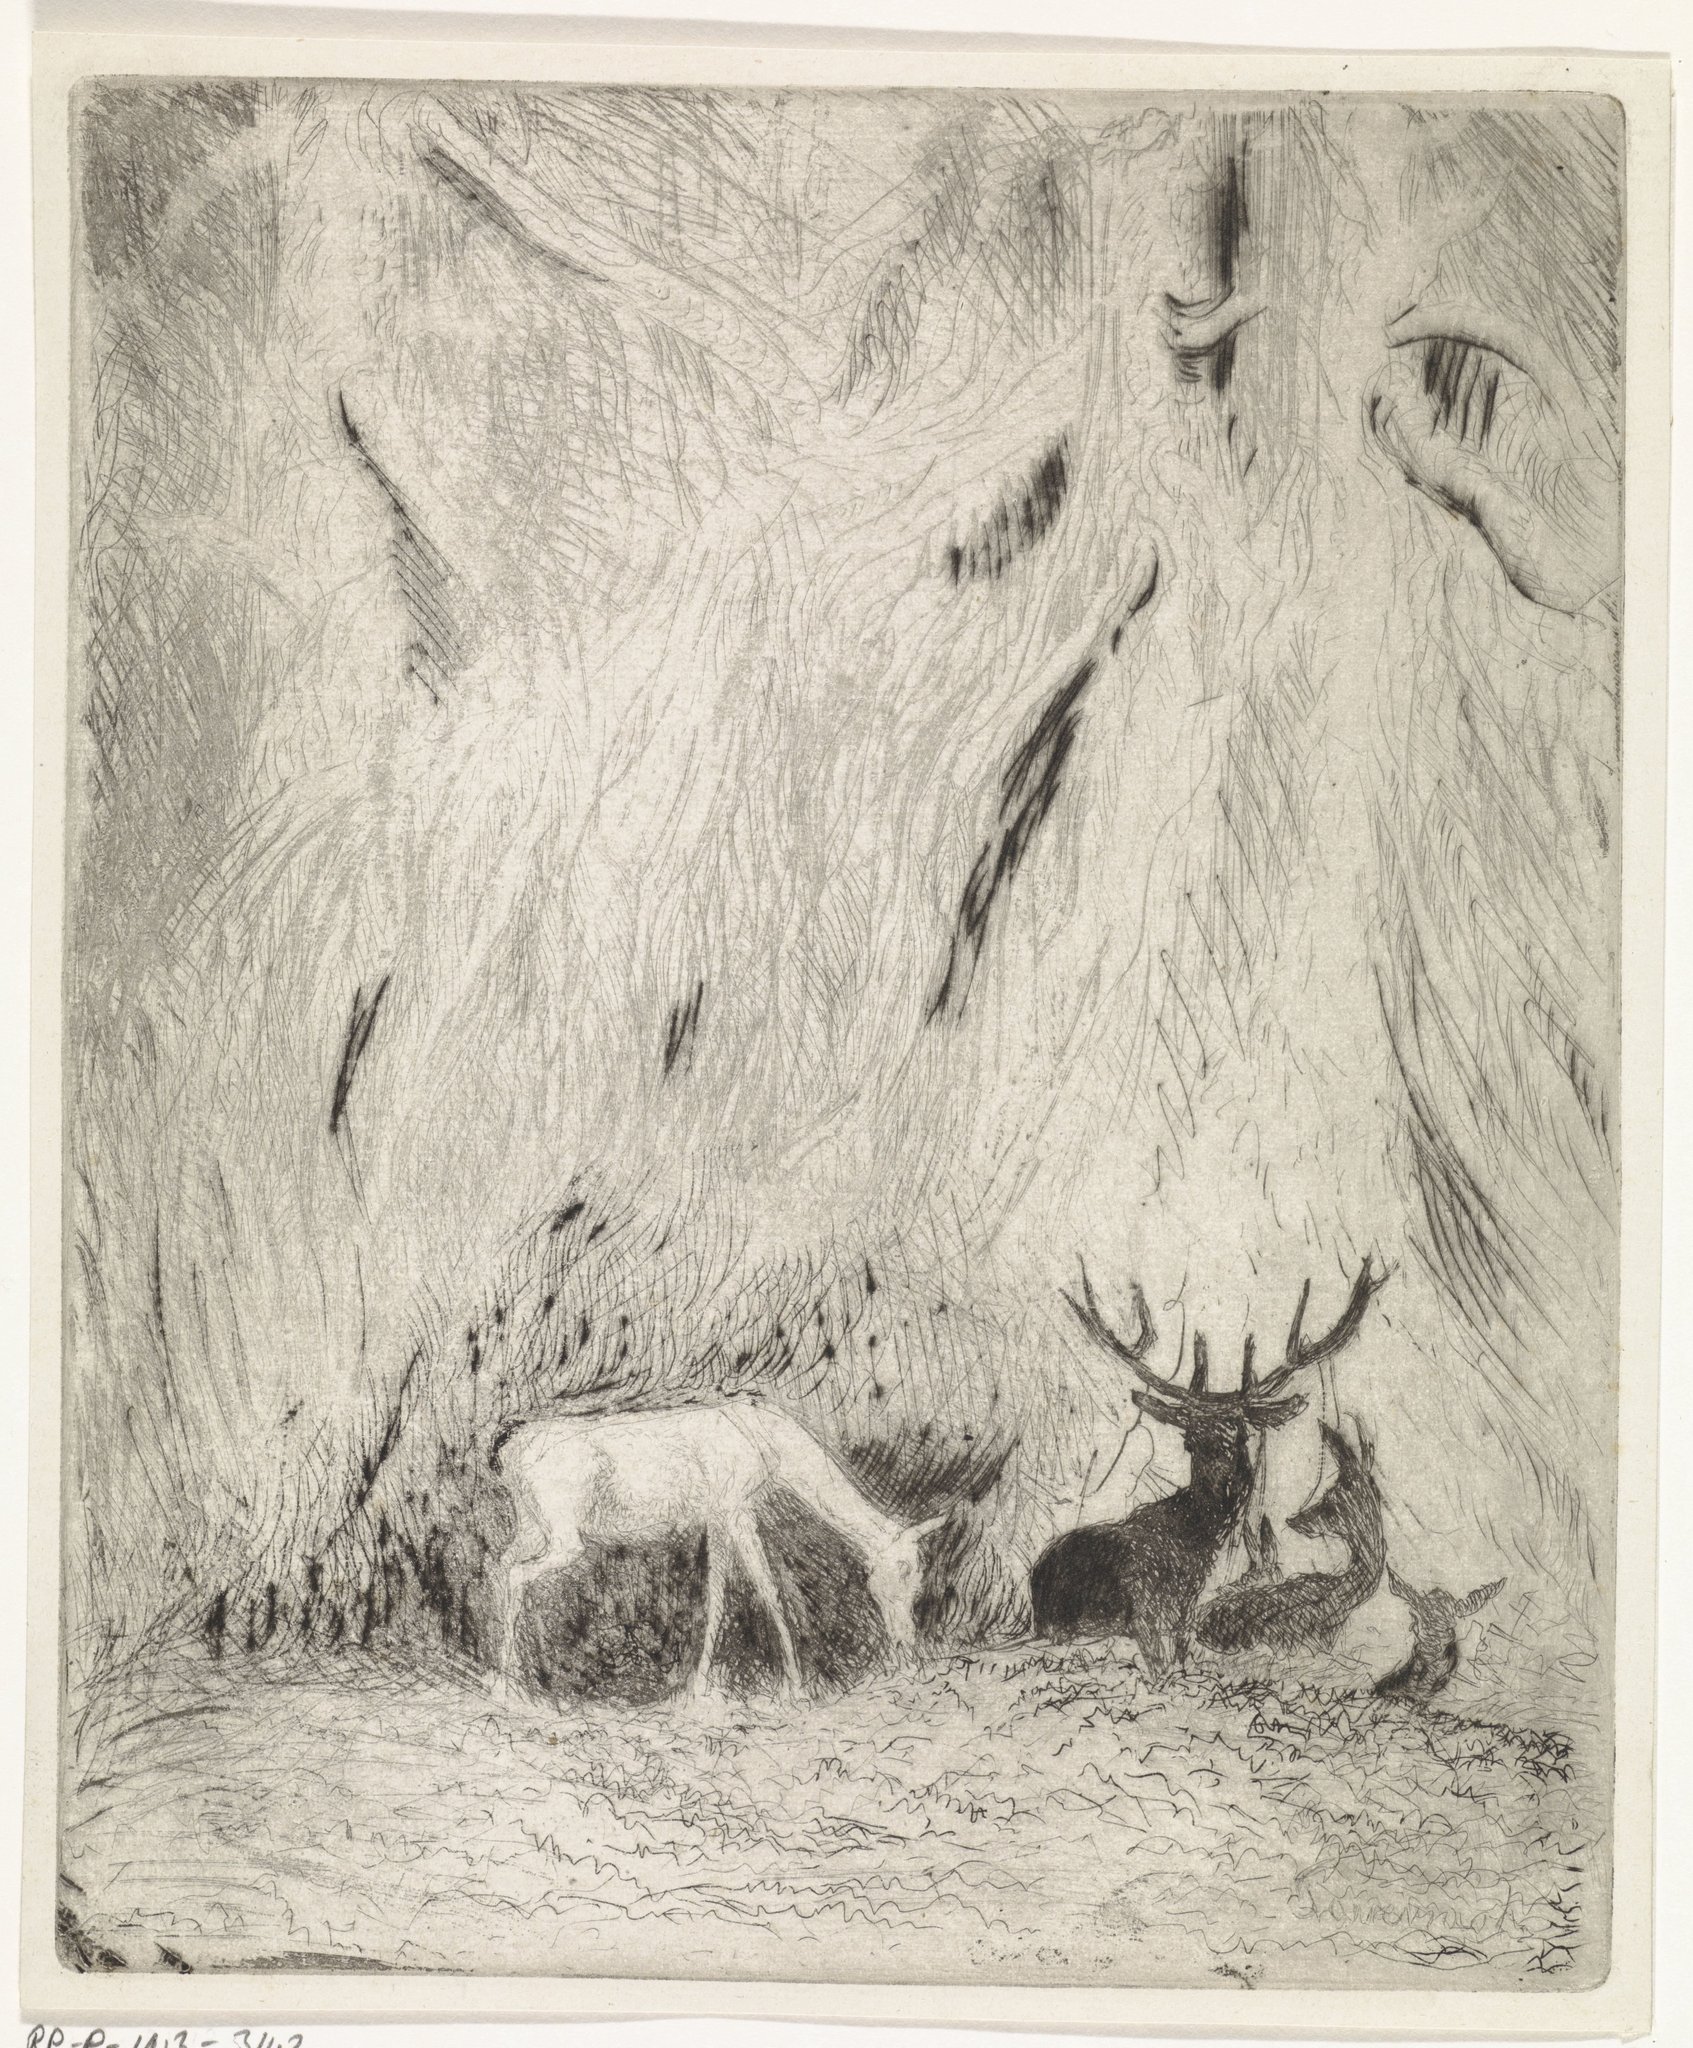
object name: print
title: Herten in een Boheems woud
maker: johannes tavenraat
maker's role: draughtsman, painter, print maker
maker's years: 1809-1881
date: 1819-1881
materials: paper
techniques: etching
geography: cleves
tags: hoofed animals: deer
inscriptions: collector's mark: Lugt 2228